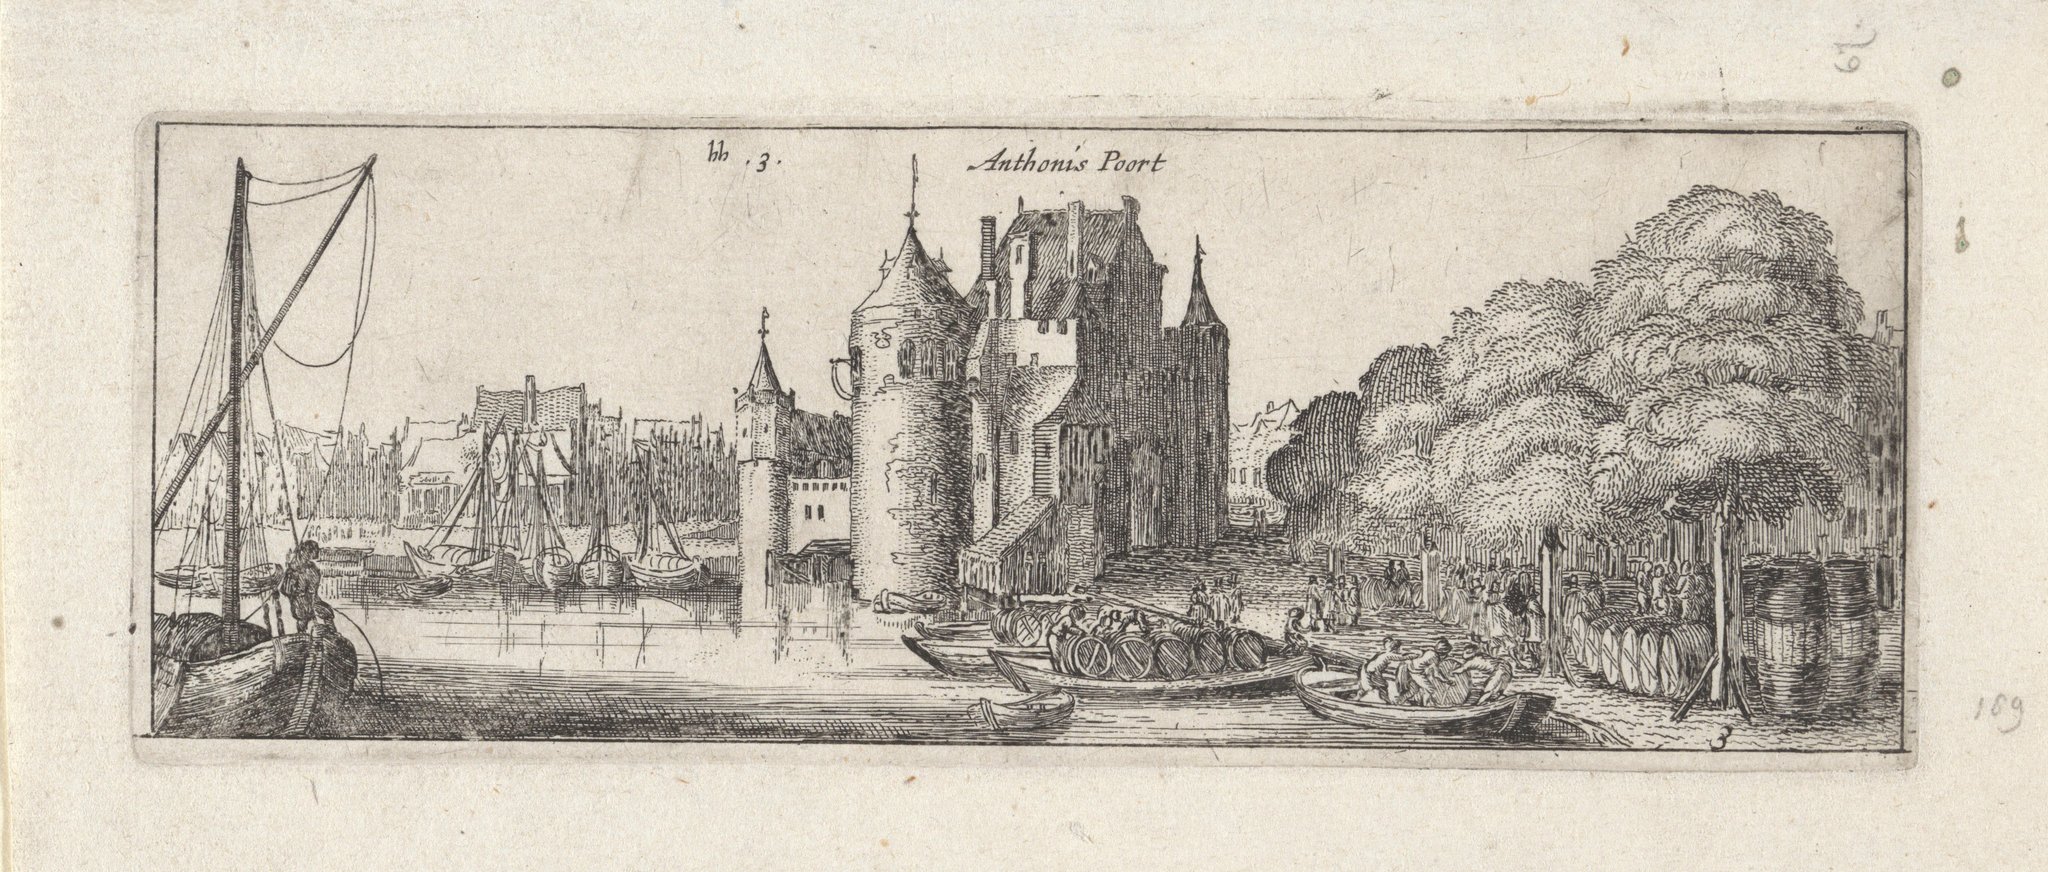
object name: print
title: Anthonis Poort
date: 1601-1652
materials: paper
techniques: engraving, etching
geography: amsterdam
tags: ships (in general), urination, city-gate, canals, waters (in city) (+ city(-scape) with figures, staffage)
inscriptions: collector's mark: Lugt 2228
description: Gezicht op de Eerste Sint-Antoniespoort te Amsterdam, gezien vanaf de Geldersekade. Op de voorgrond verschillende boten. Dit vijftiende-eeuwse gebouw kwam na de stadsuitbreidingen uit het einde van de zestiende eeuw binnen de stad (op de Nieuwmarkt) te liggen en verloor zo zijn functie als stadspoort. In 1617-1618 werd het ingericht als waag. Boven links van het midden genummerd: hh. 3. Rechtsonder genummerd: 3.